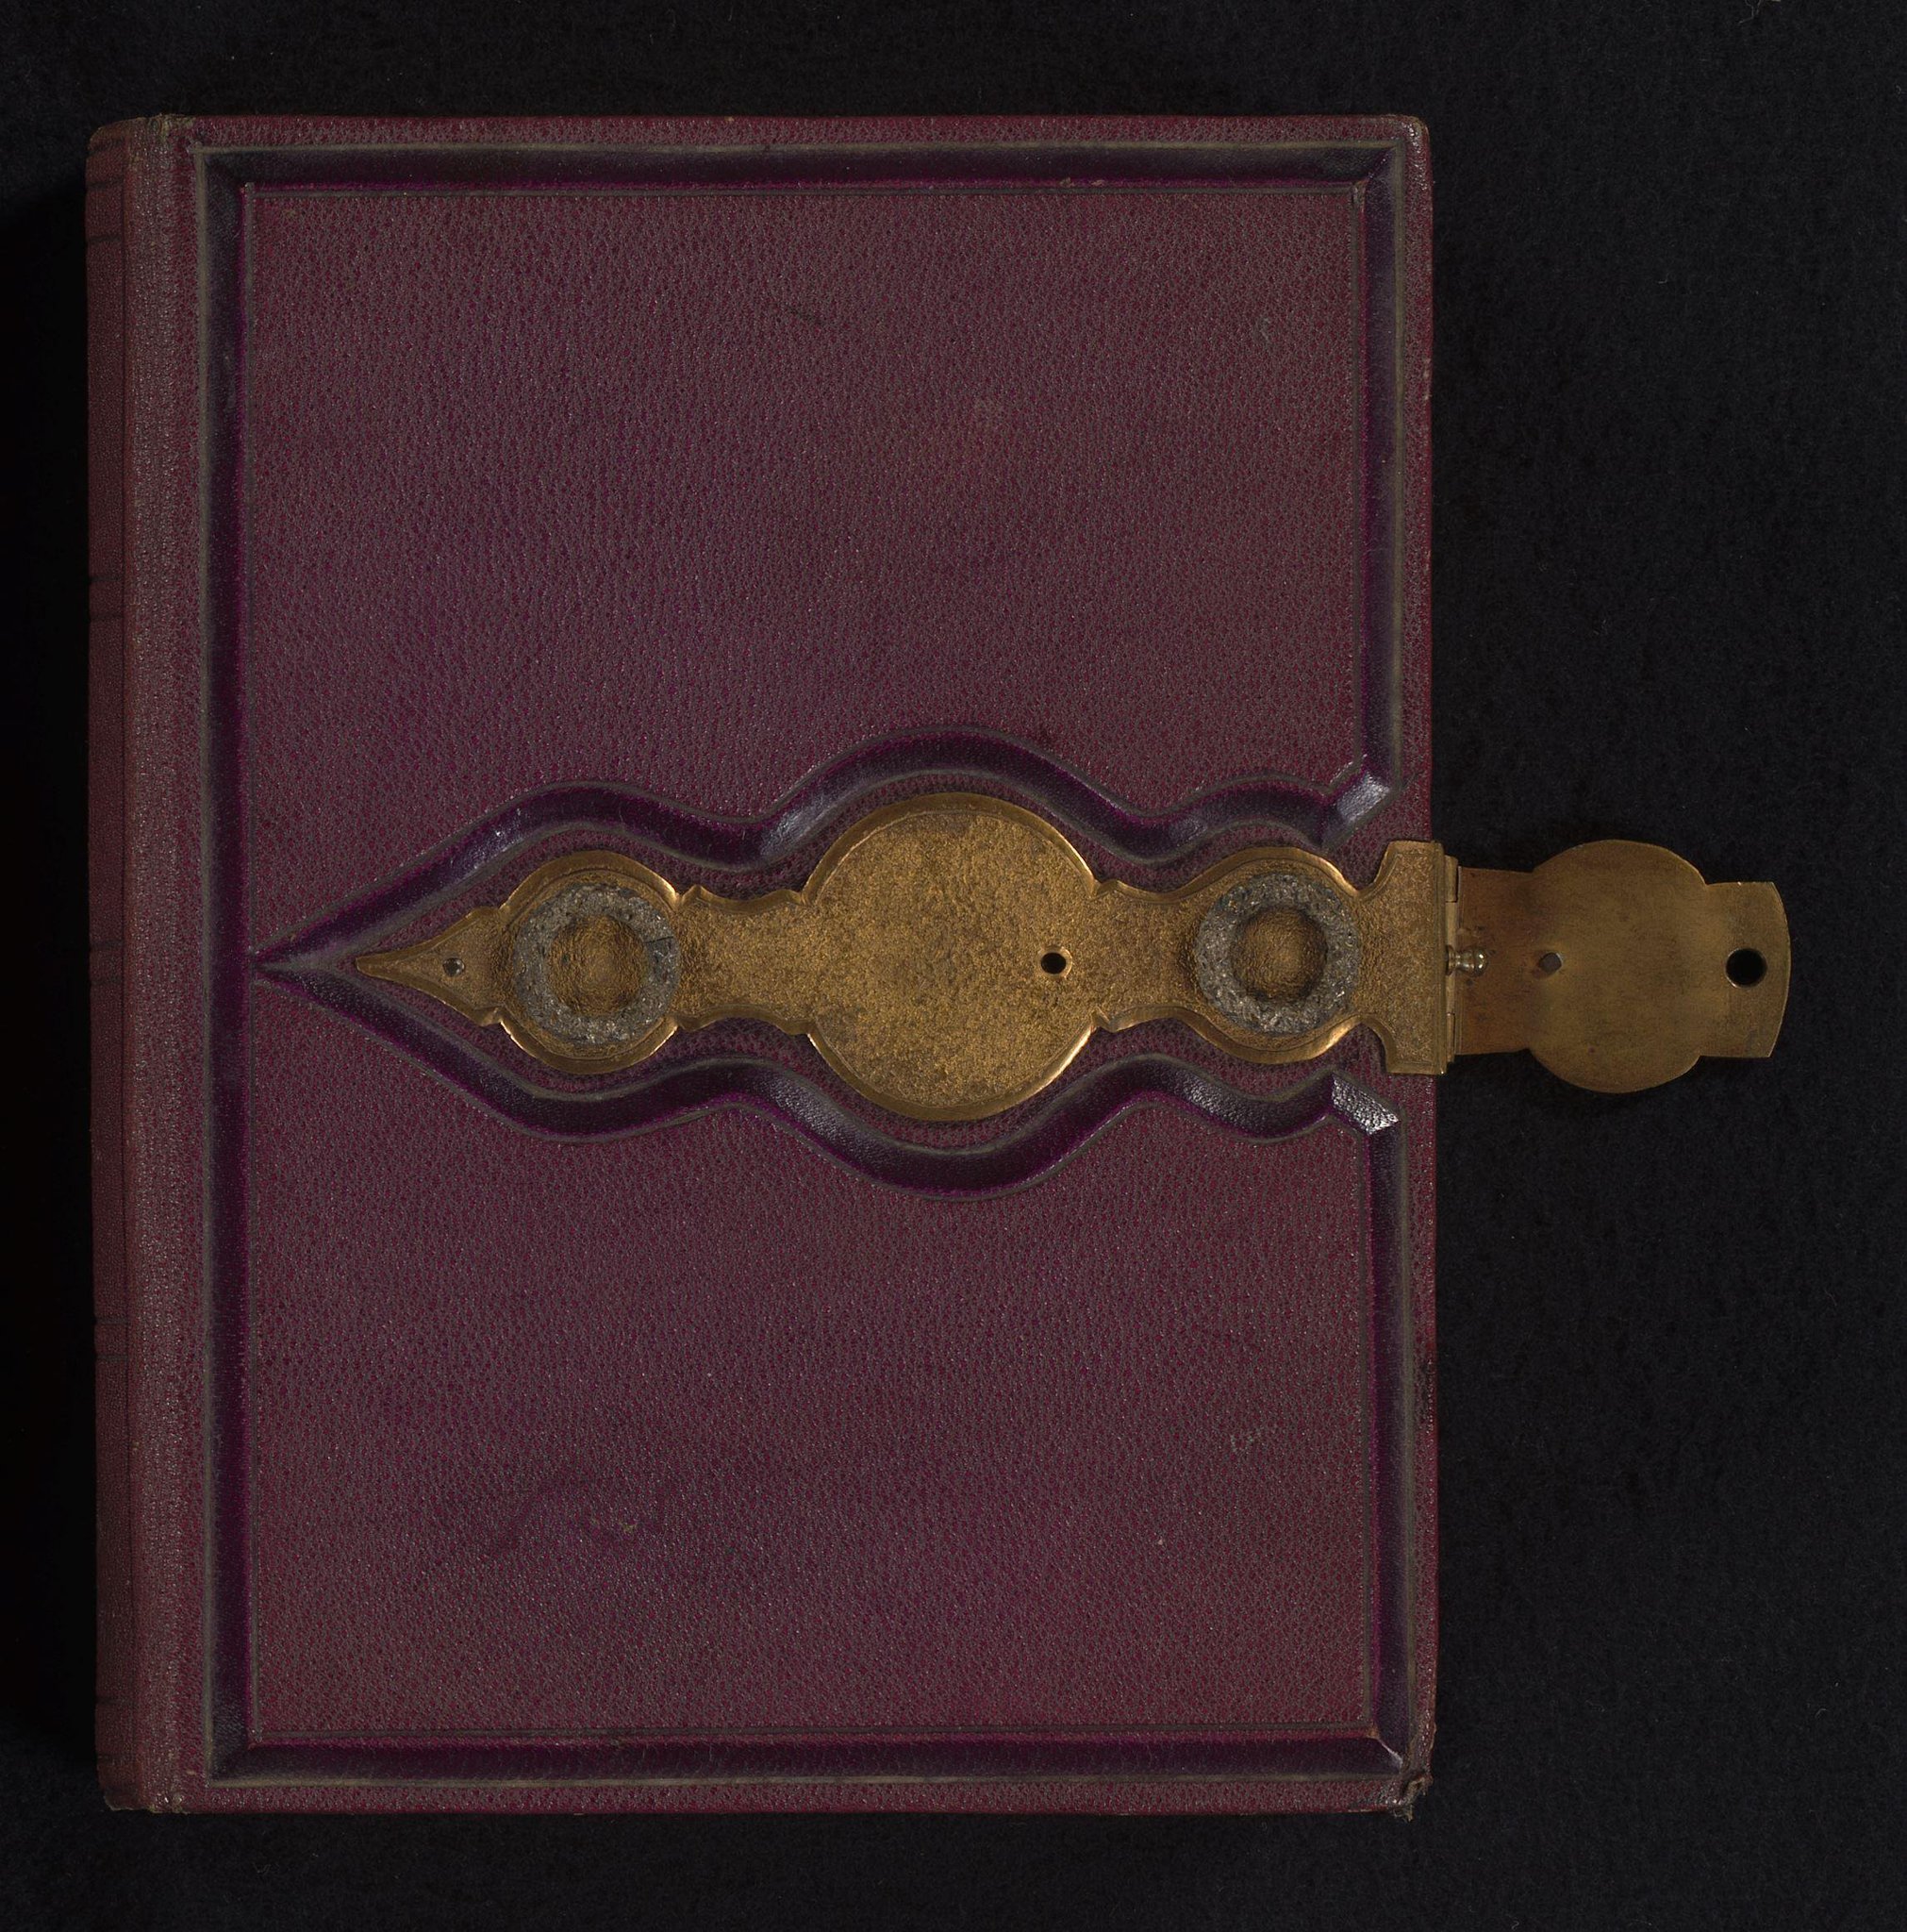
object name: photograph album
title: Fotoalbum (leeg)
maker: Anonymous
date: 1860-1900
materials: cardboard, leather, metal, paper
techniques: color on snow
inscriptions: collector's mark: ‘DIENST/ VERSPREIDE/ RIJKSKOLLEKTIES/ (...) A 804’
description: Fotoalbum met 36 pagina's met ieder een met gouden lijnen omkaderde passe-partout voor een carte-de-visite.